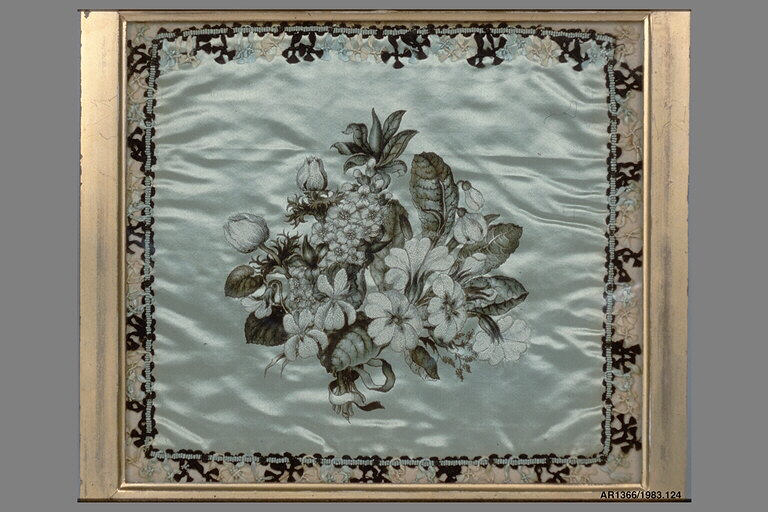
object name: picture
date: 1701-1800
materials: ink, silk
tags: flowers